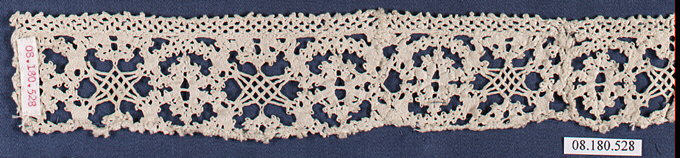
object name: insertion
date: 1601-1700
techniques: lace